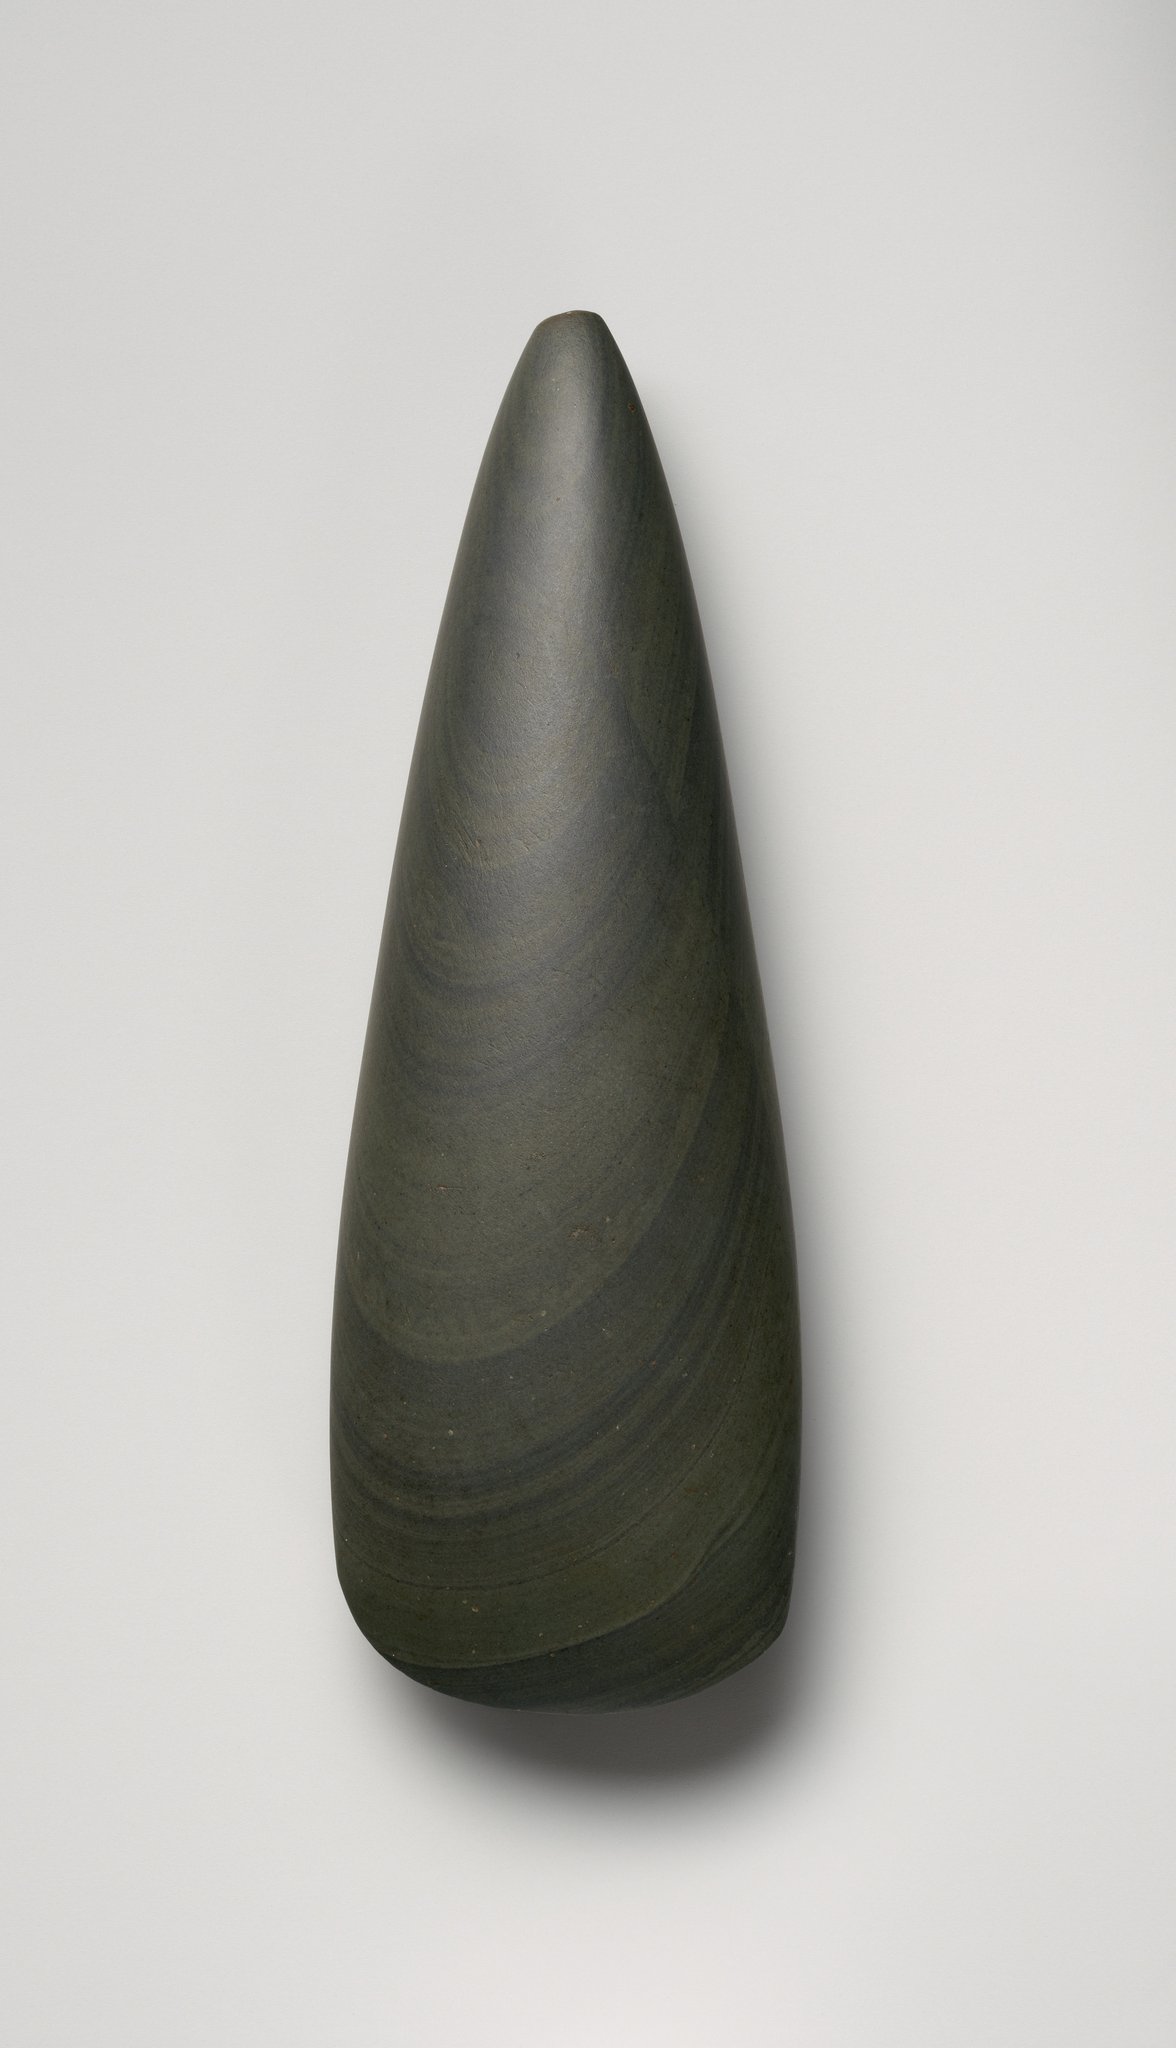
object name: celt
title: Ceremonial axe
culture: taíno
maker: taíno artist(s)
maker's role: artist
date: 600-1500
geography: dominican republic